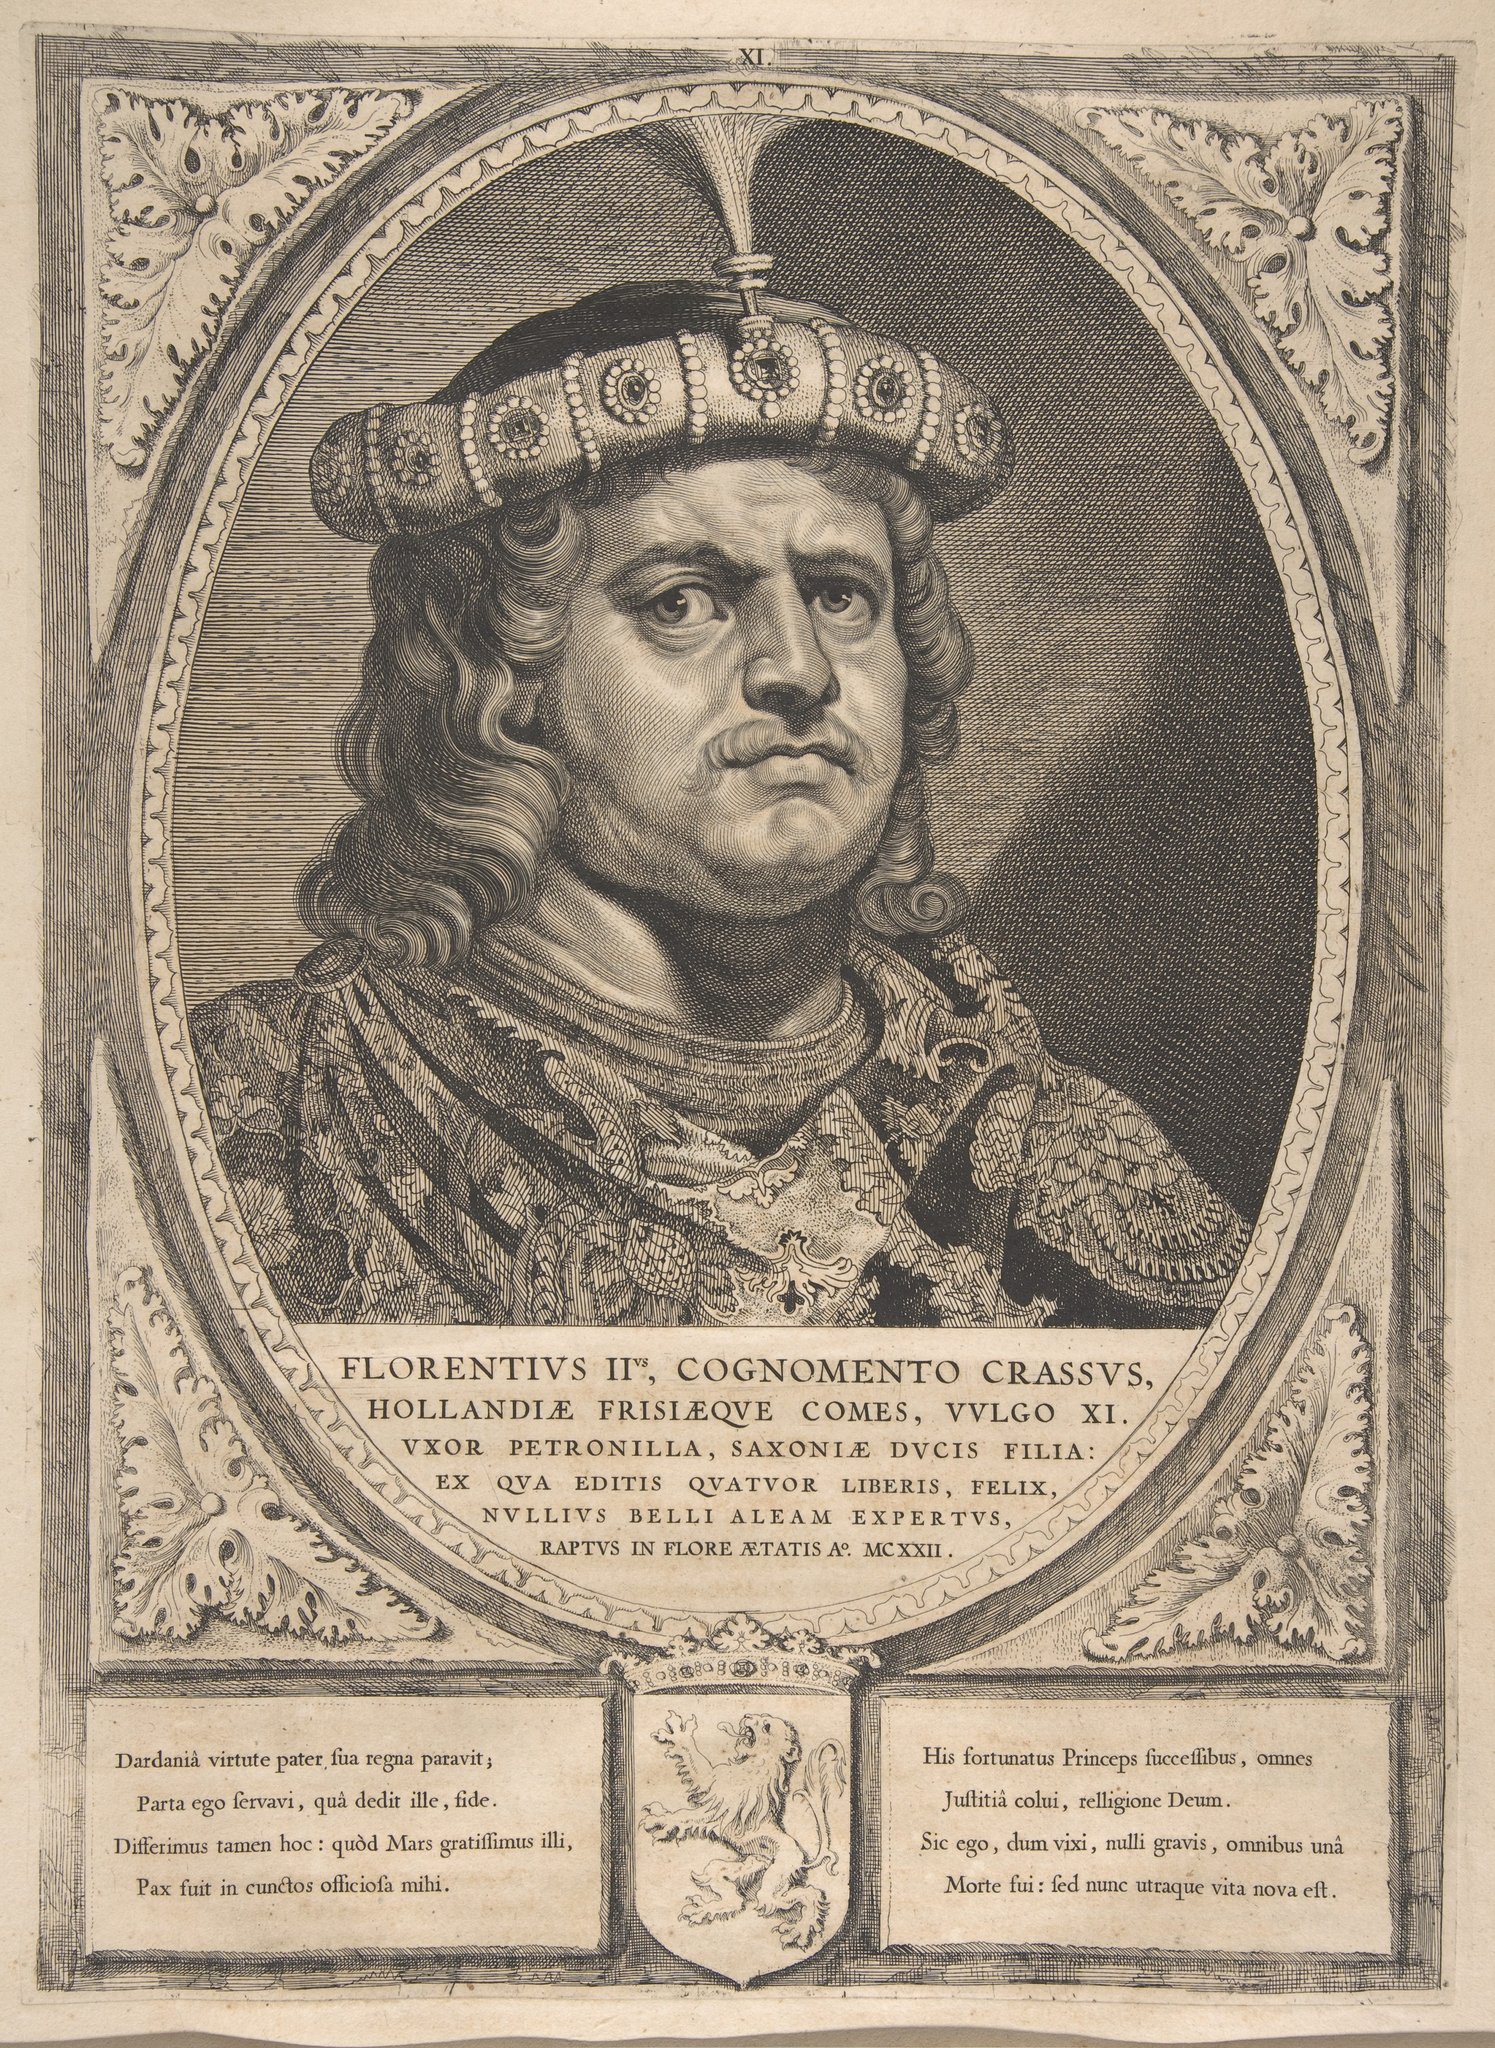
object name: print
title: Floris II from the series Counts and Countesses of Holland, Zeeland, and West-Frisia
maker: pieter soutman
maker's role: artist and publisher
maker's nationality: dutch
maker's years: 1580-1657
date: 1650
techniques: engraving, etching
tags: men,portraits,coat of arms